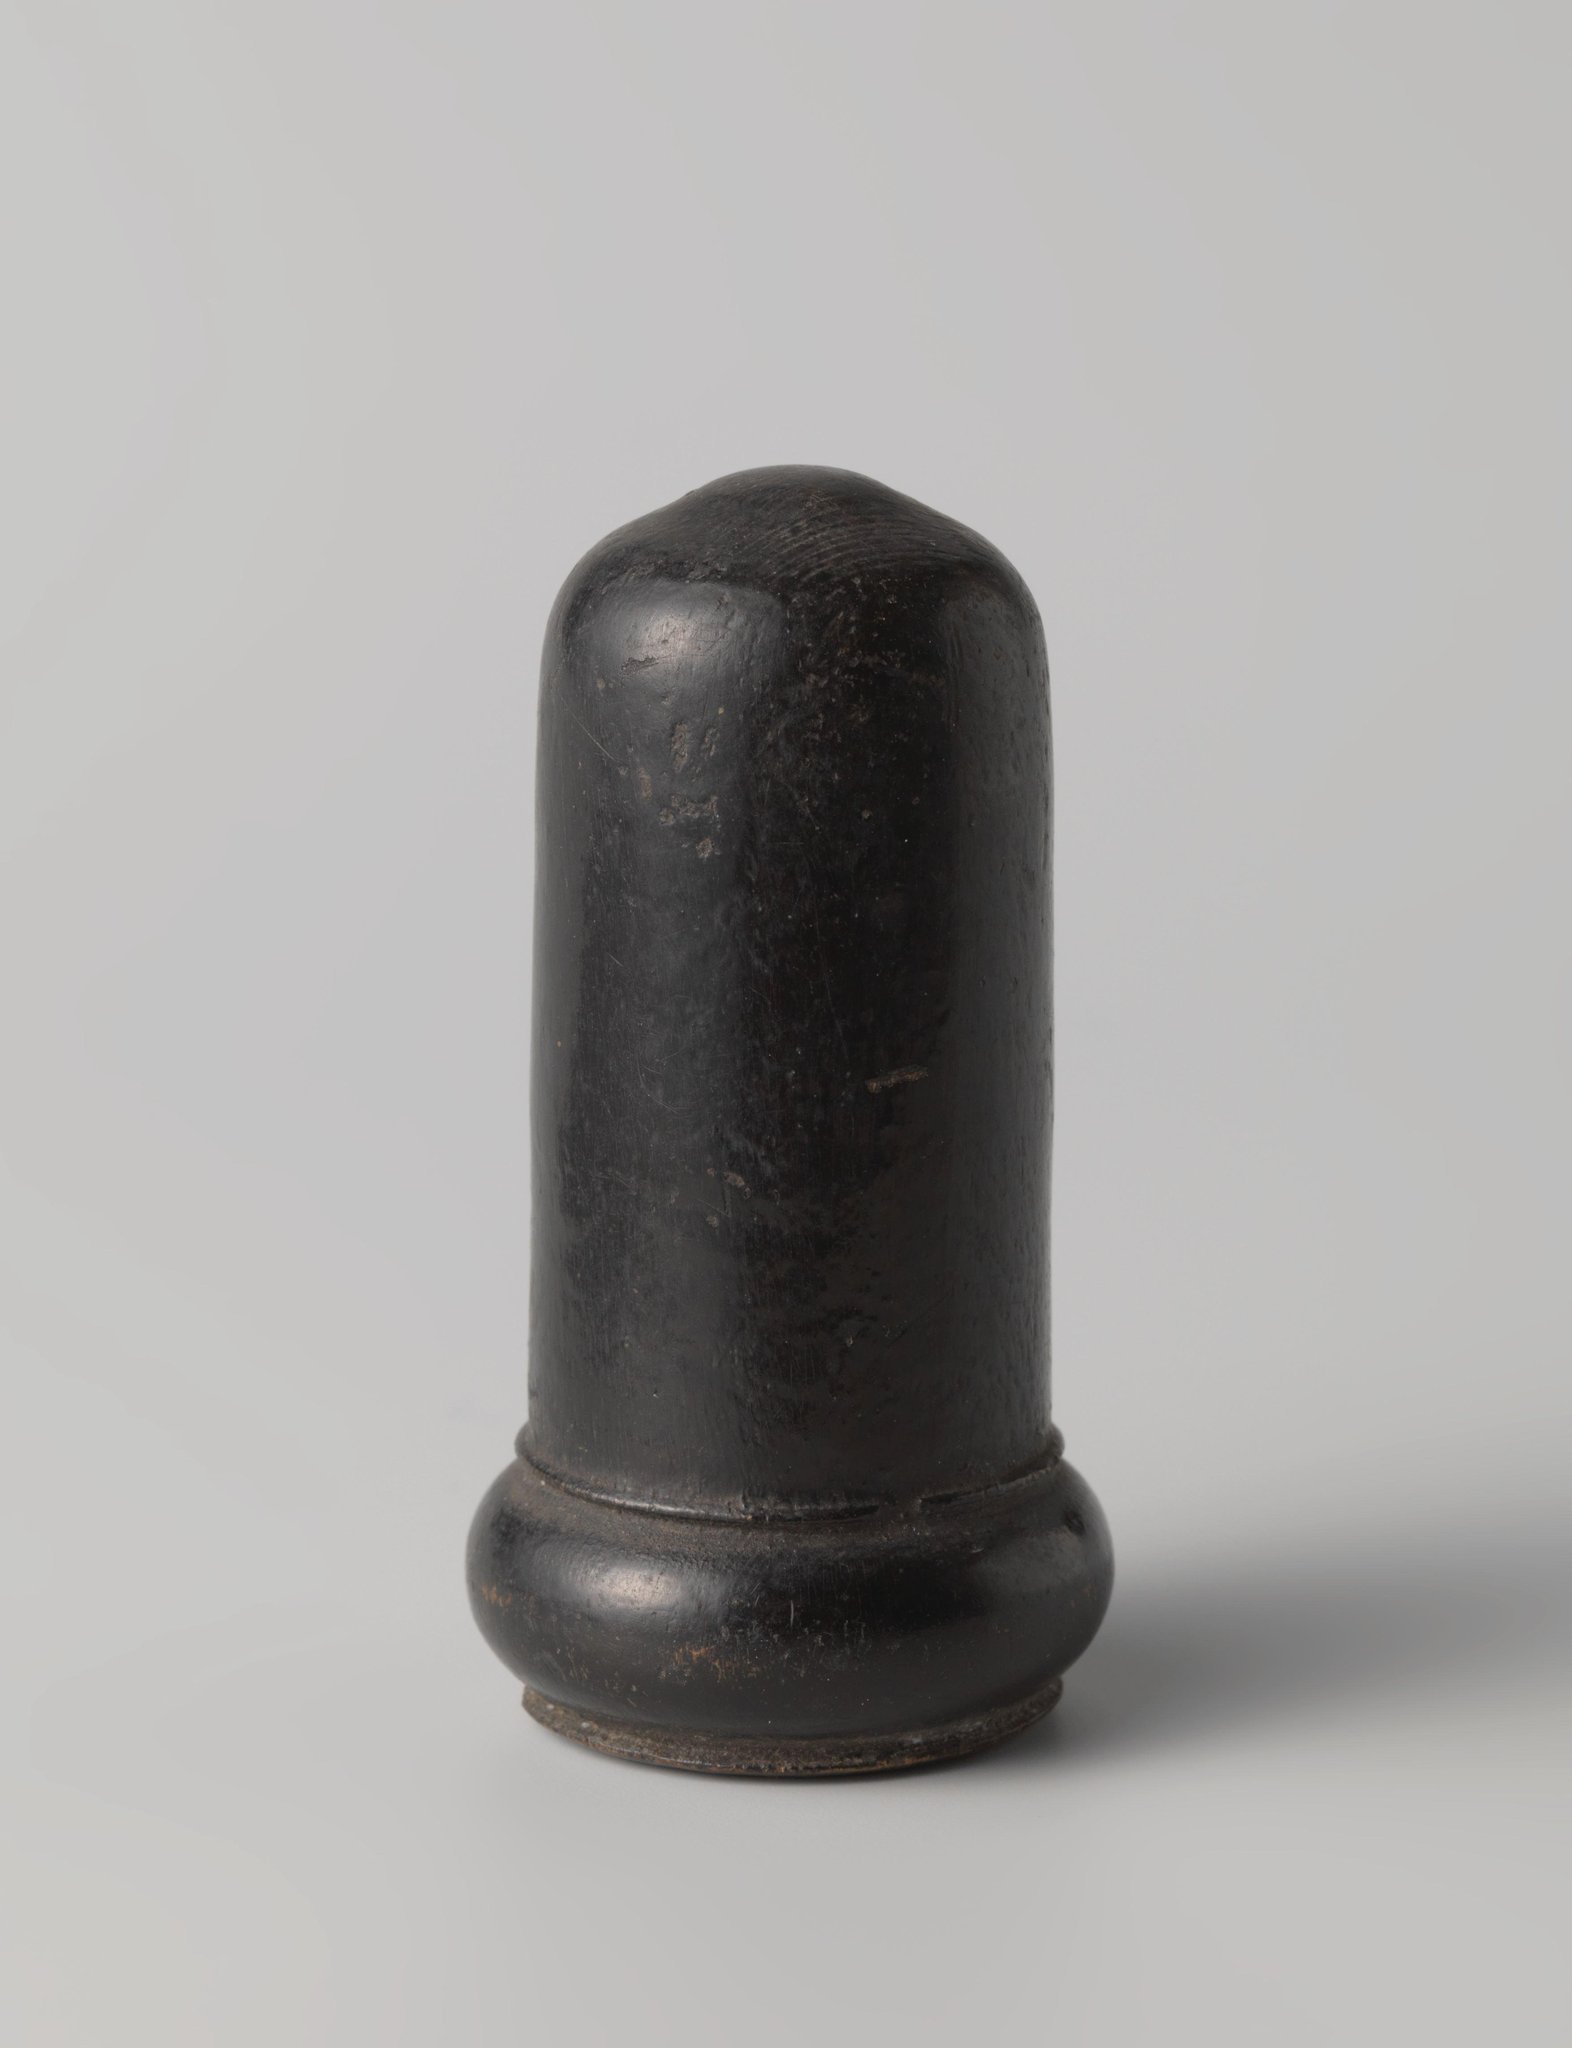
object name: musical instrument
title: Clarinet mouthpiece cover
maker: Anonymous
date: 1800-1850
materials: wood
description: Klarinet mondstuk cap om rieten te beschermen. Horend bij vijf dekstukken (BK-NM-11430-124-A t/m BK-NM-11430-124-F).